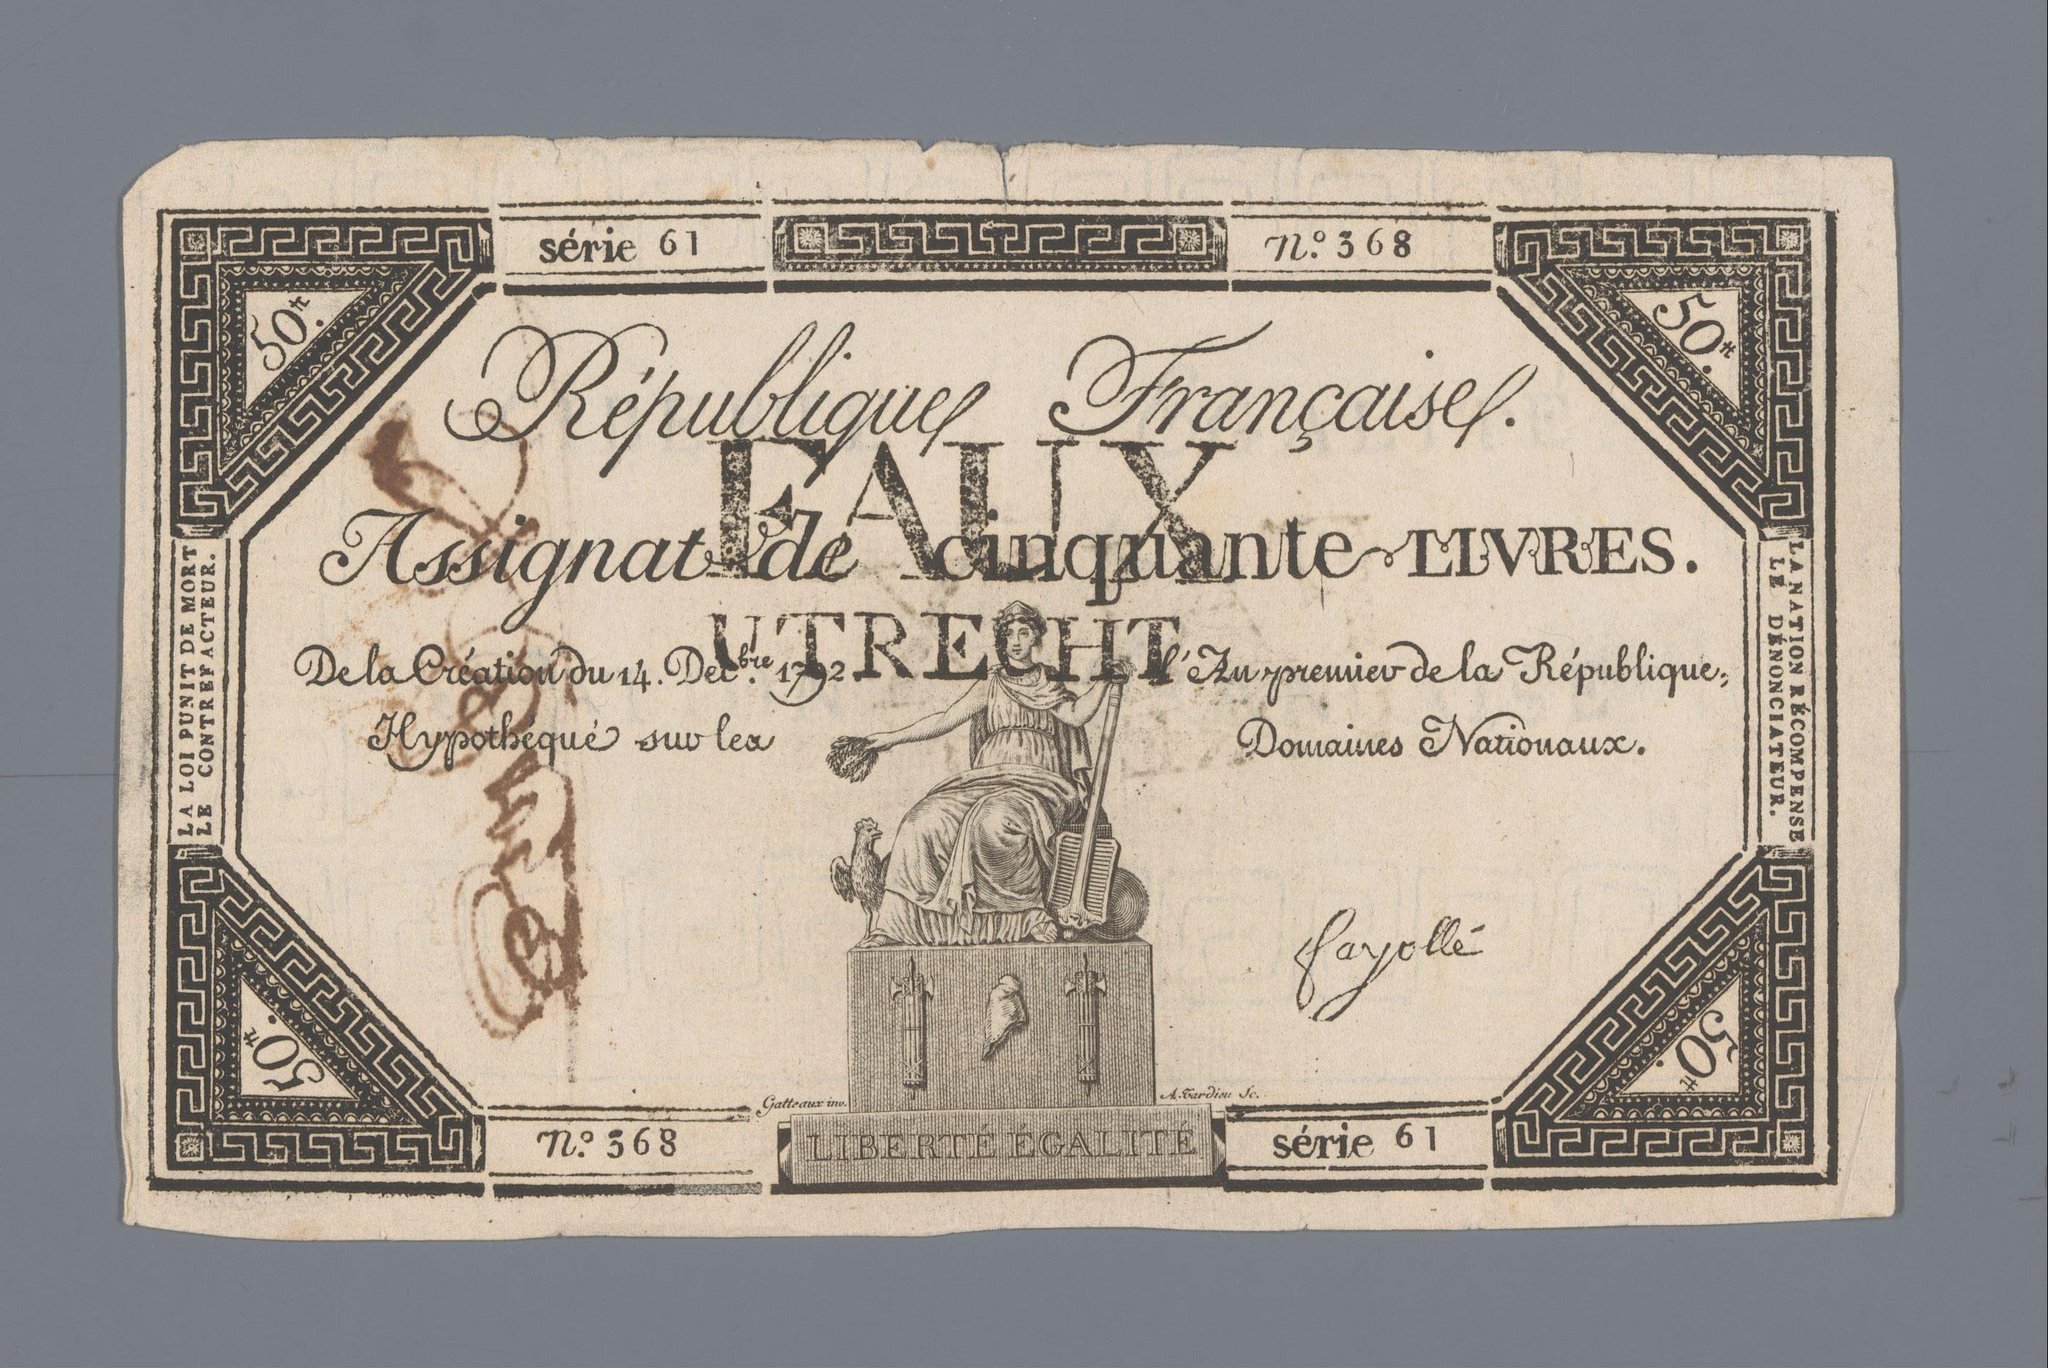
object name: assignat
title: Te Utrecht ongeldig gemaakte assignat van vijftig livres, serie 61, nr. 368 uitgegeven 14 december 1792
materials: paper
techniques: printing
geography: paris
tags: utrecht